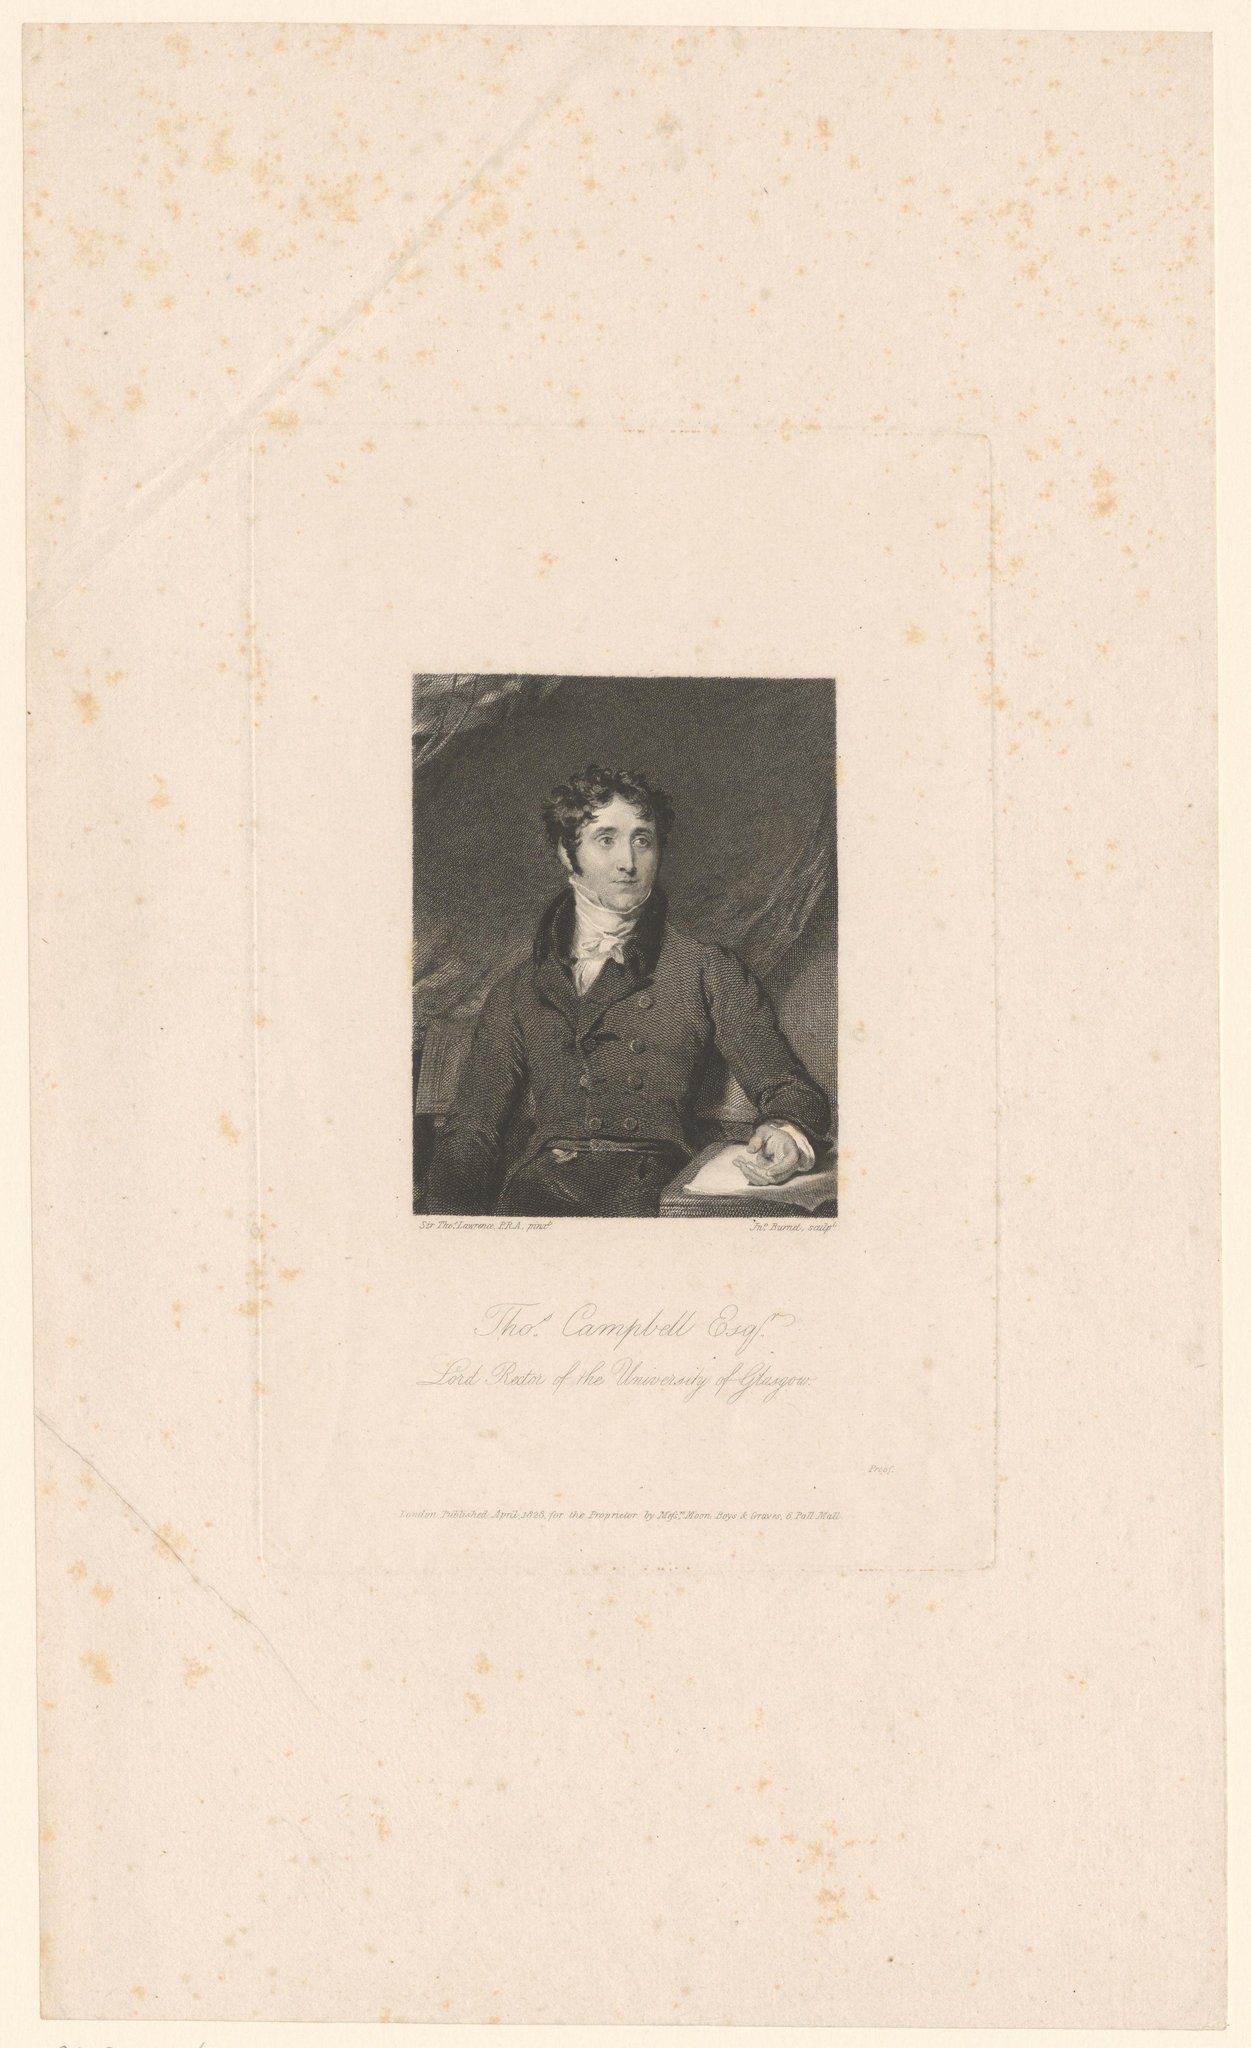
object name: book illustration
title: Portret van Thomas Campbell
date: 1804-1828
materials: paper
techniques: engraving, etching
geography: london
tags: historical persons, portrait of a writer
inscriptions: collector's mark: Lugt 2228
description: Prent uit: Campbell, Thomas. The Poetical Works. Londen: Moon, Boys & Graves, 1828.